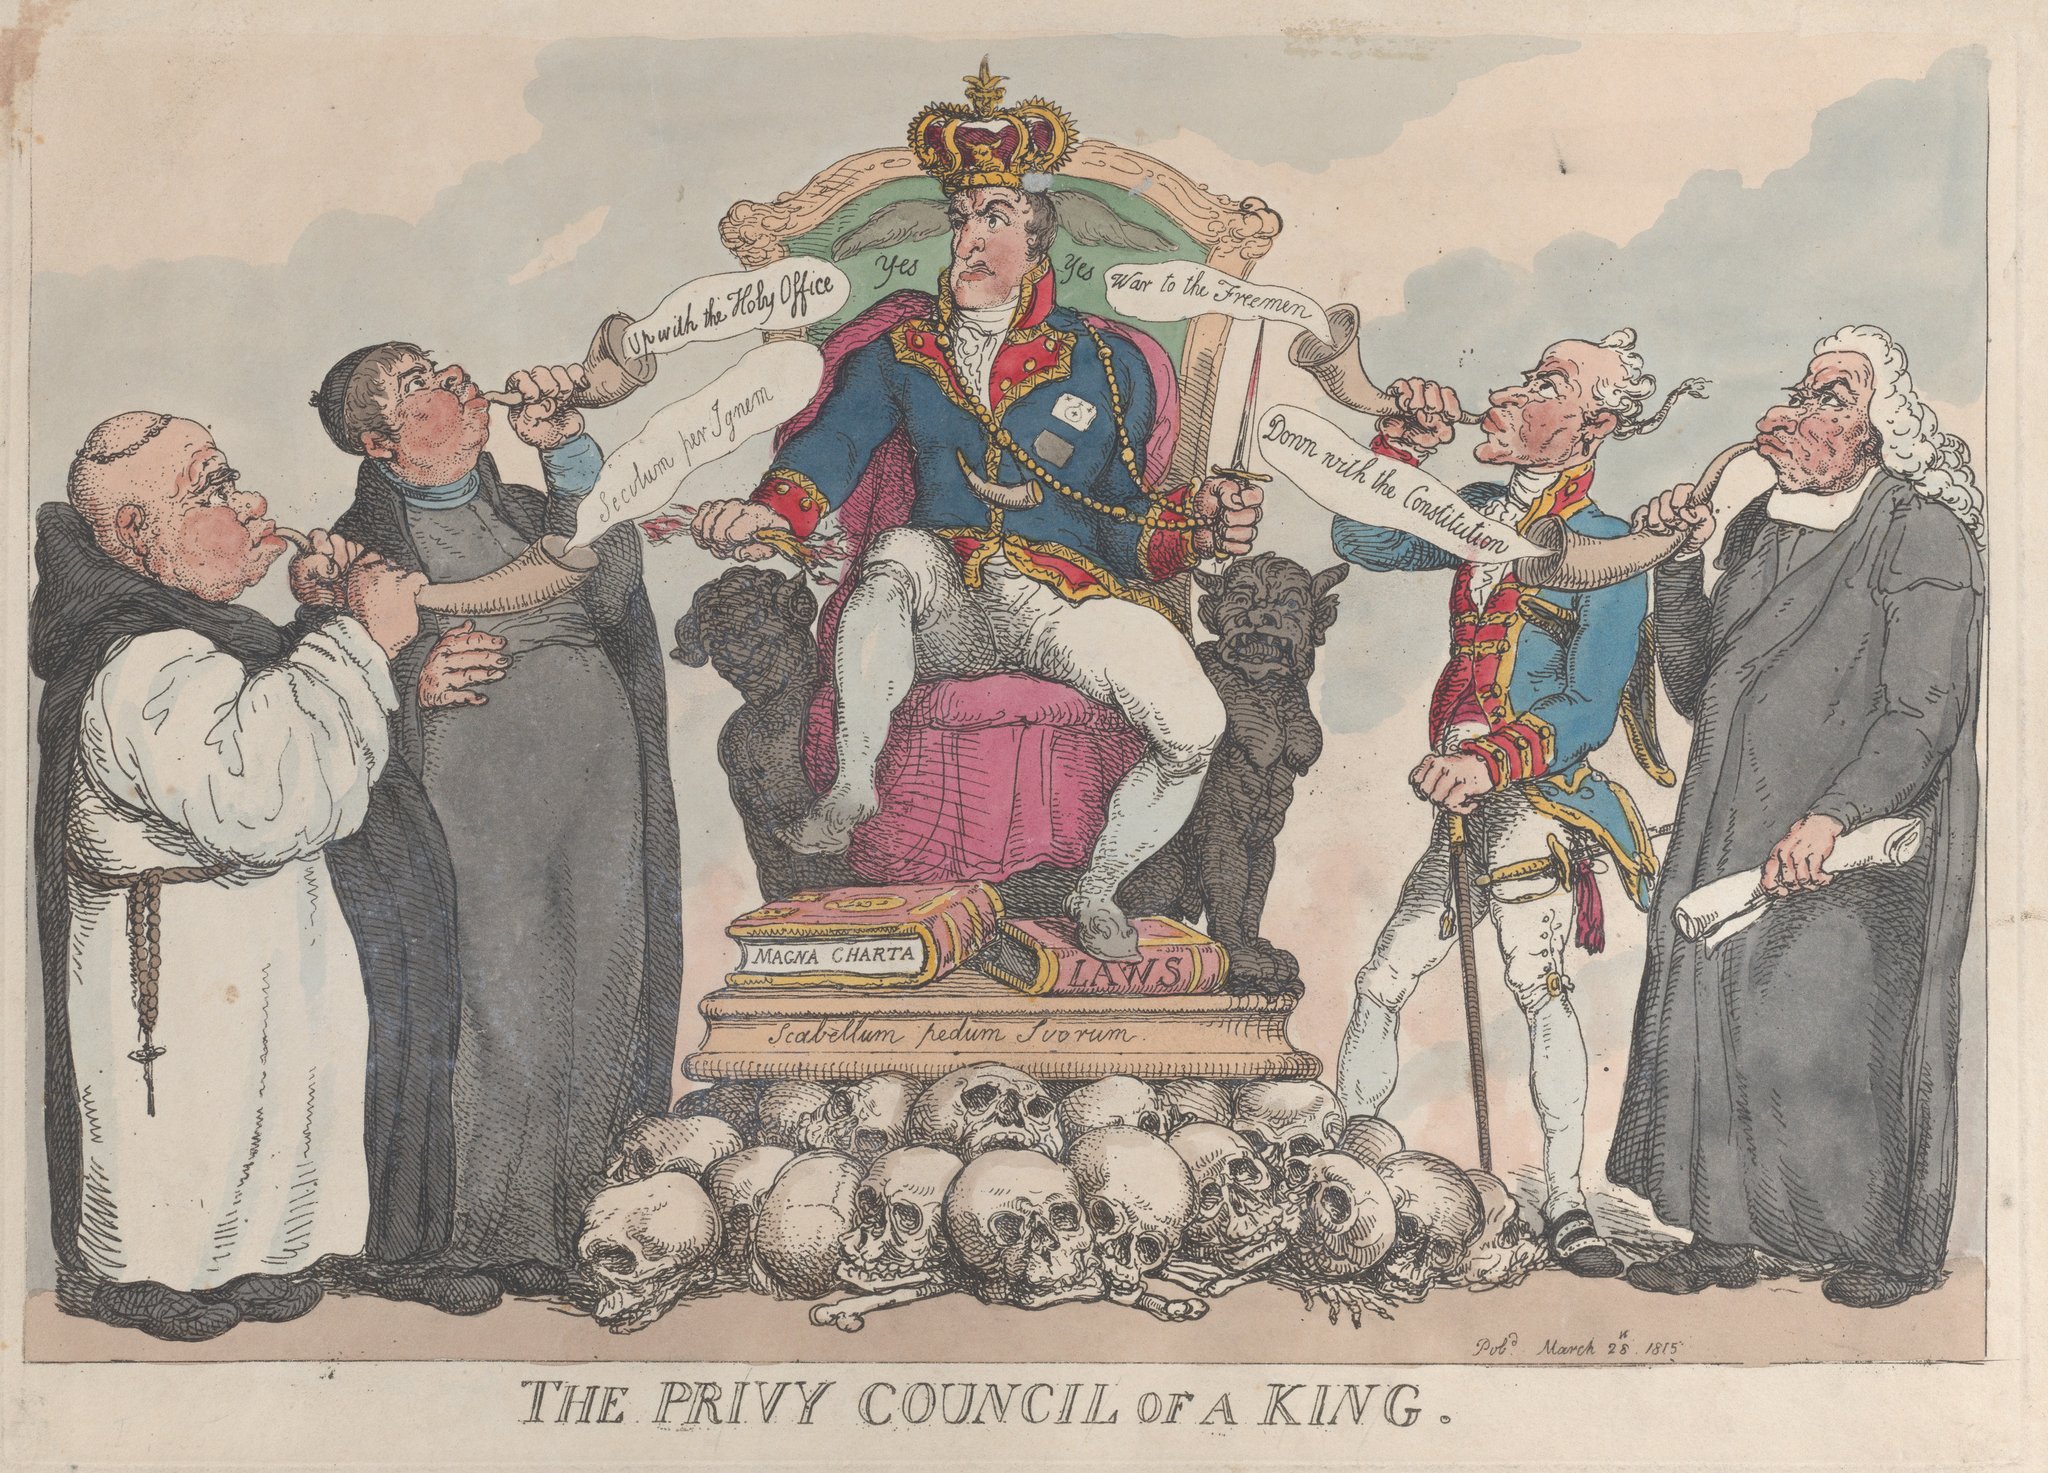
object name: print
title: The Privy Council of a King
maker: thomas rowlandson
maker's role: artist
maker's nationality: british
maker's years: 1757-1827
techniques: etching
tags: satire,skulls,men,politics